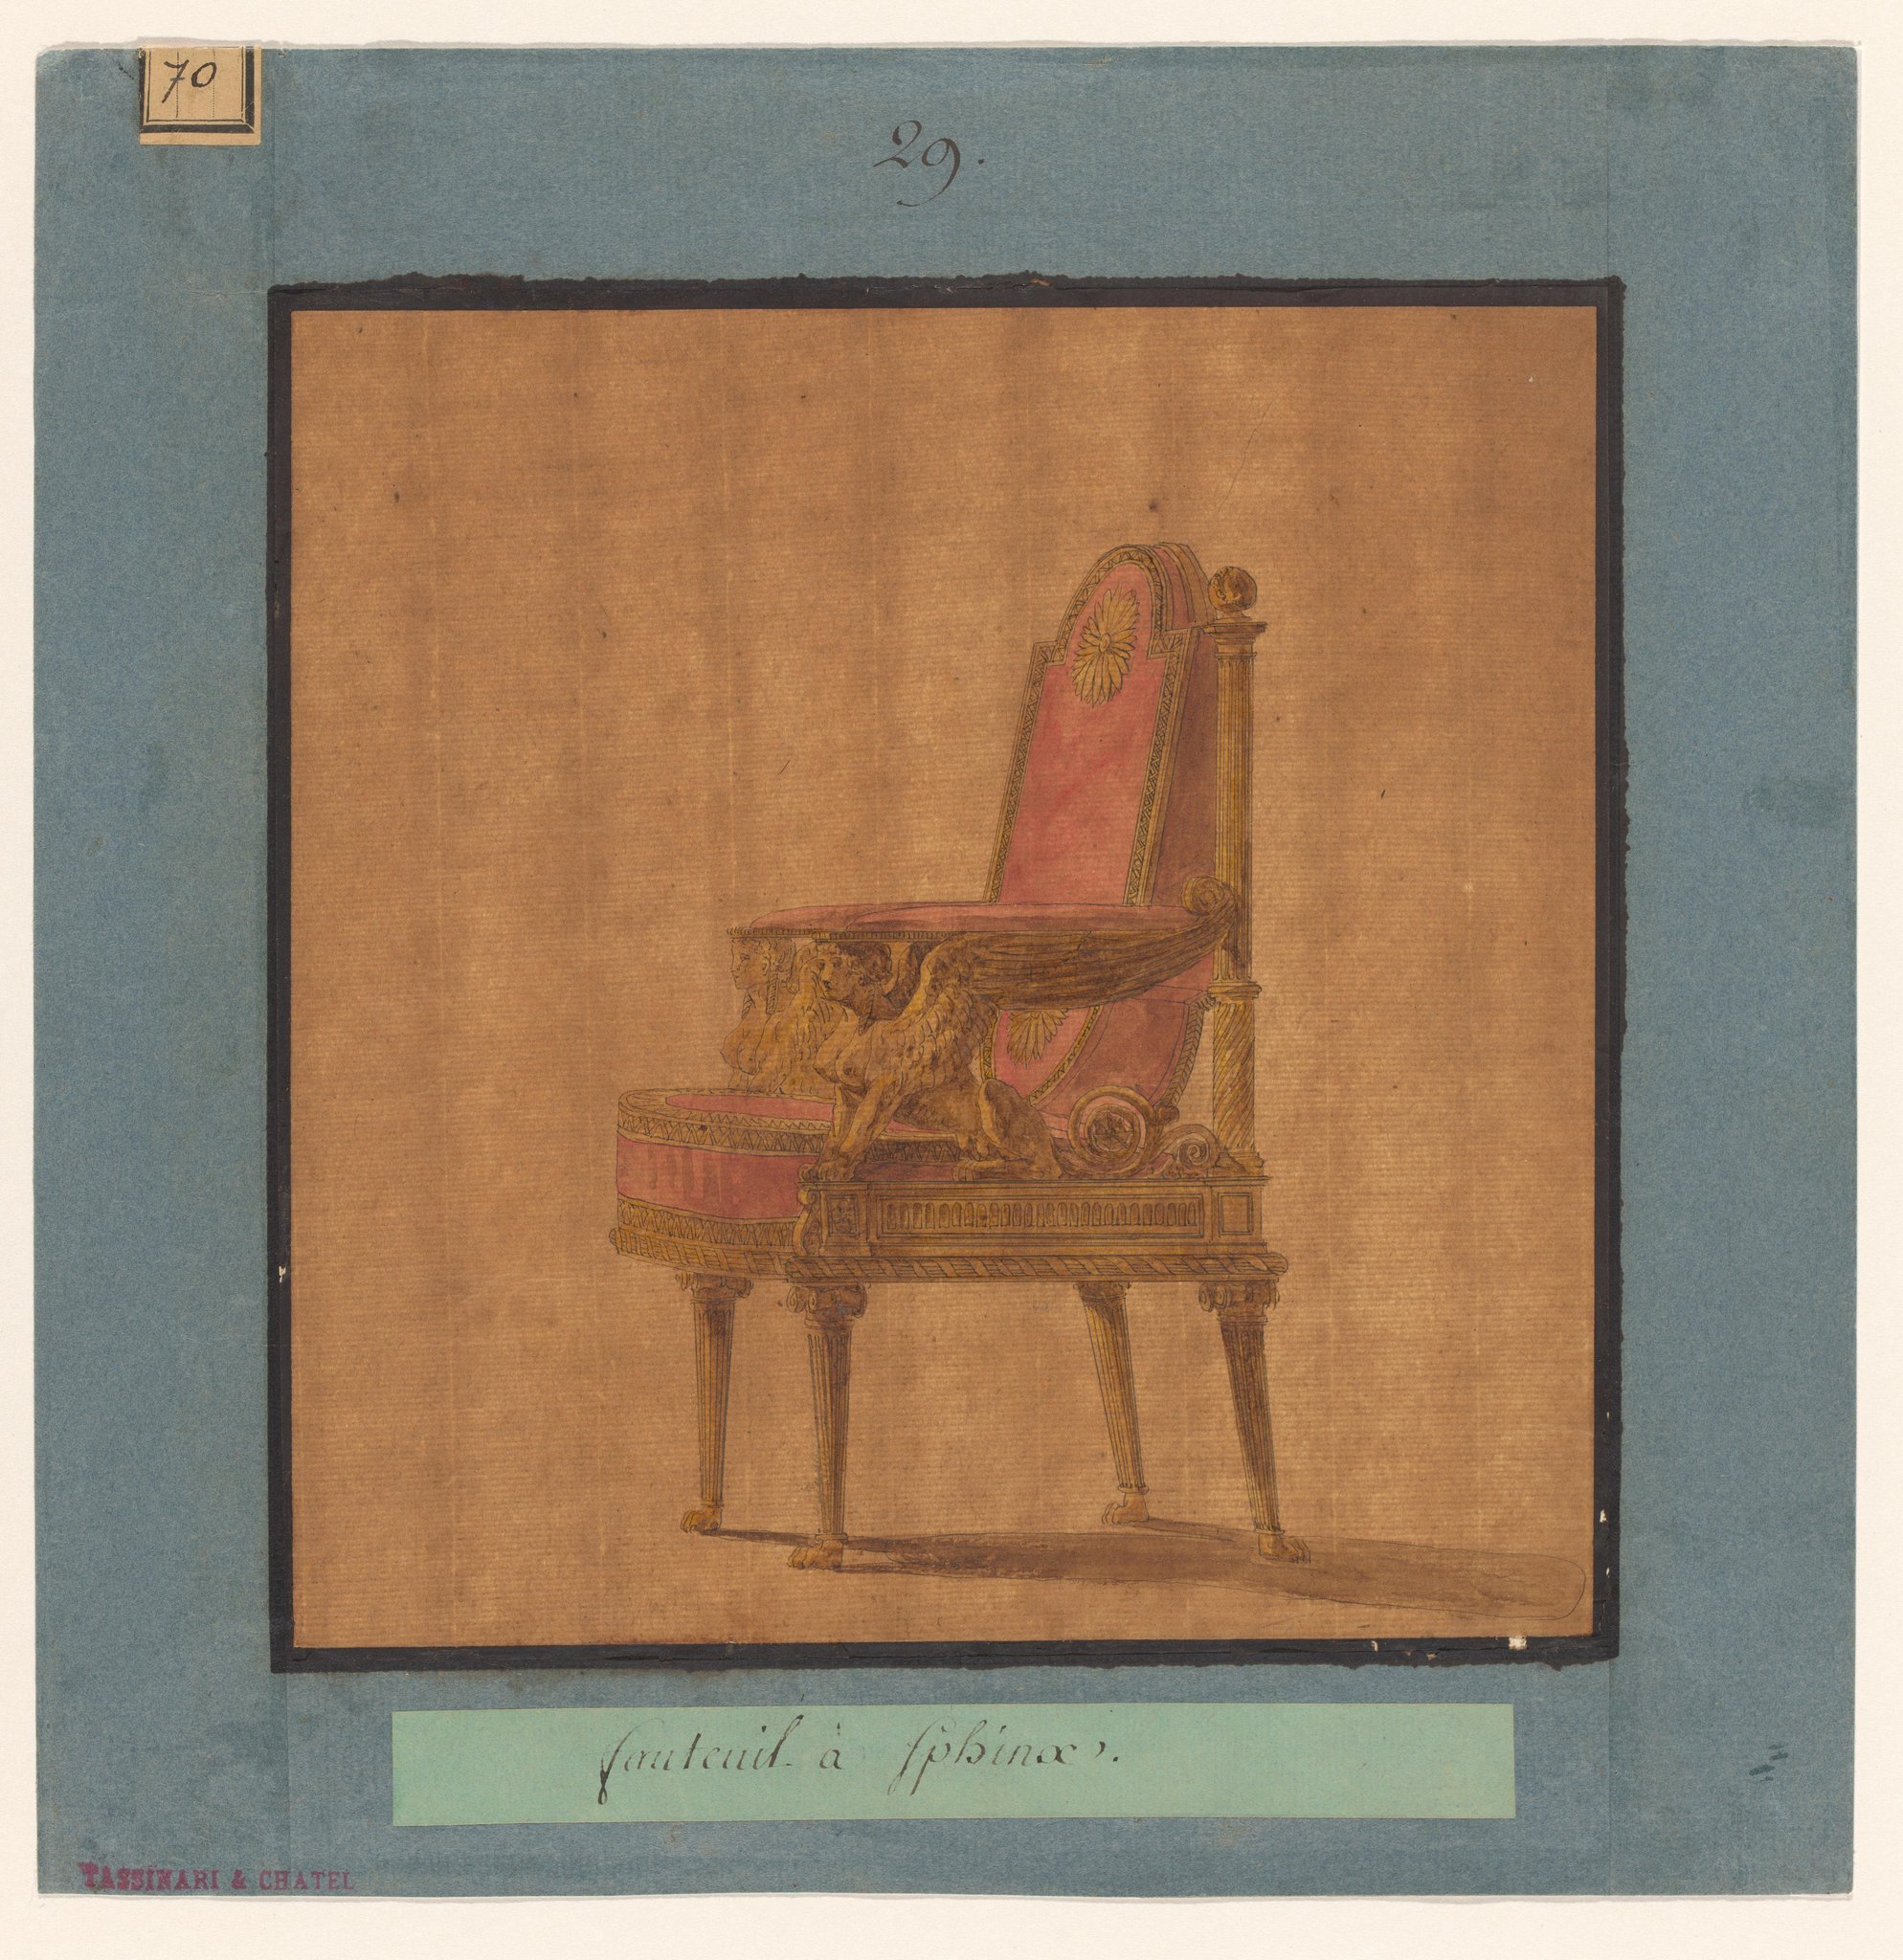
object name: design drawing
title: Ontwerp voor een fauteuil met armsteunen in de vorm van sfinxen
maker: jean démosthène dugourc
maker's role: draughtsman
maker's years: 1749-1825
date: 1784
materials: ink, paper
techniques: brush, pen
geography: paris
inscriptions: label: ‘fauteuil à sphinx’, number: ‘29’, stamp: ‘TASSINARI & CHATEL.’, number: ‘70’, stamp: ‘CHATEL & TASSINARI’